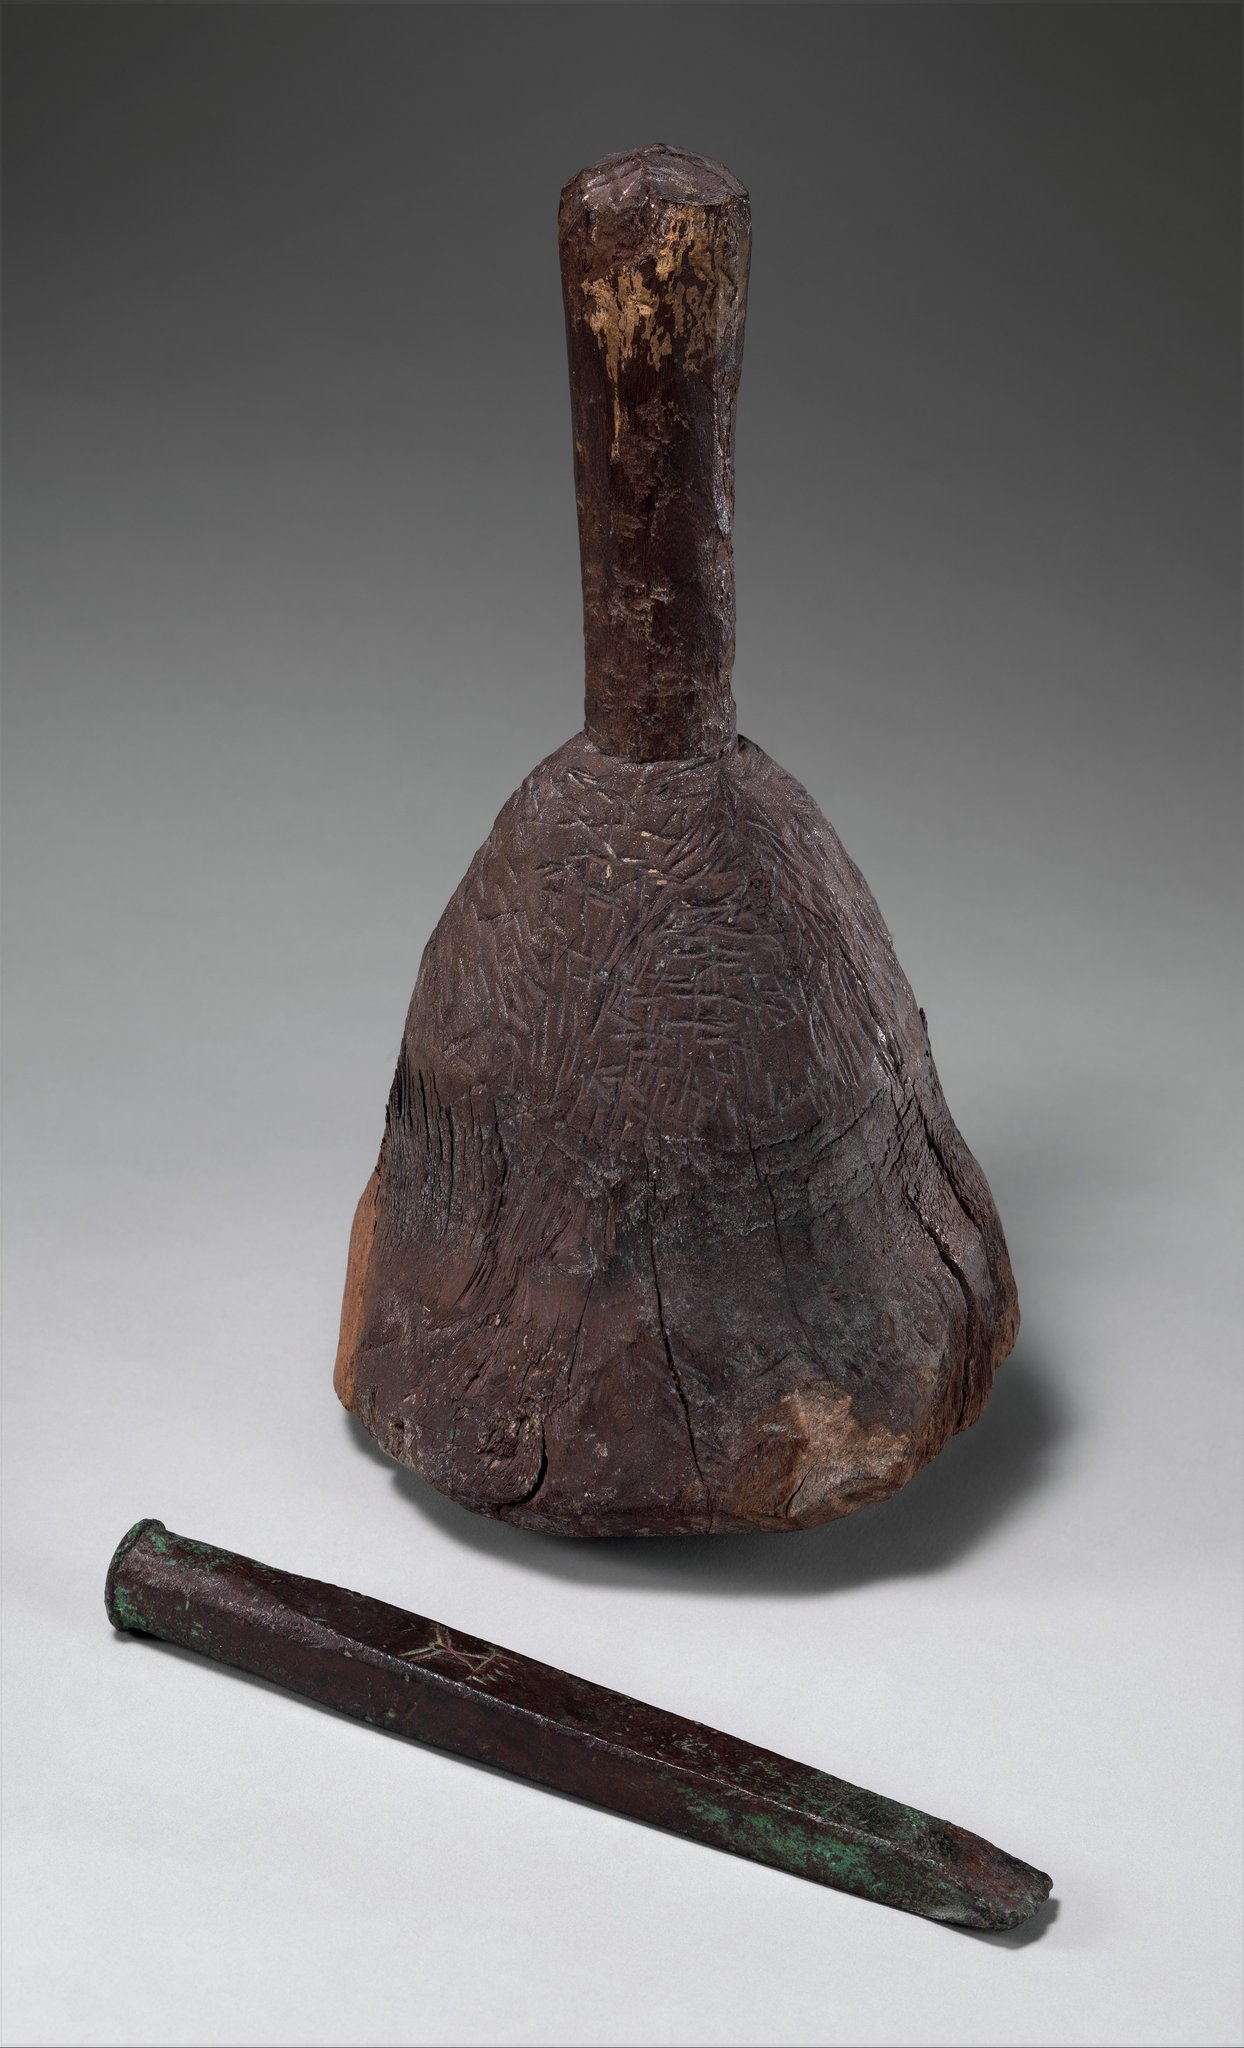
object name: mallet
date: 1961-1917 BCE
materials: wood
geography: egypt